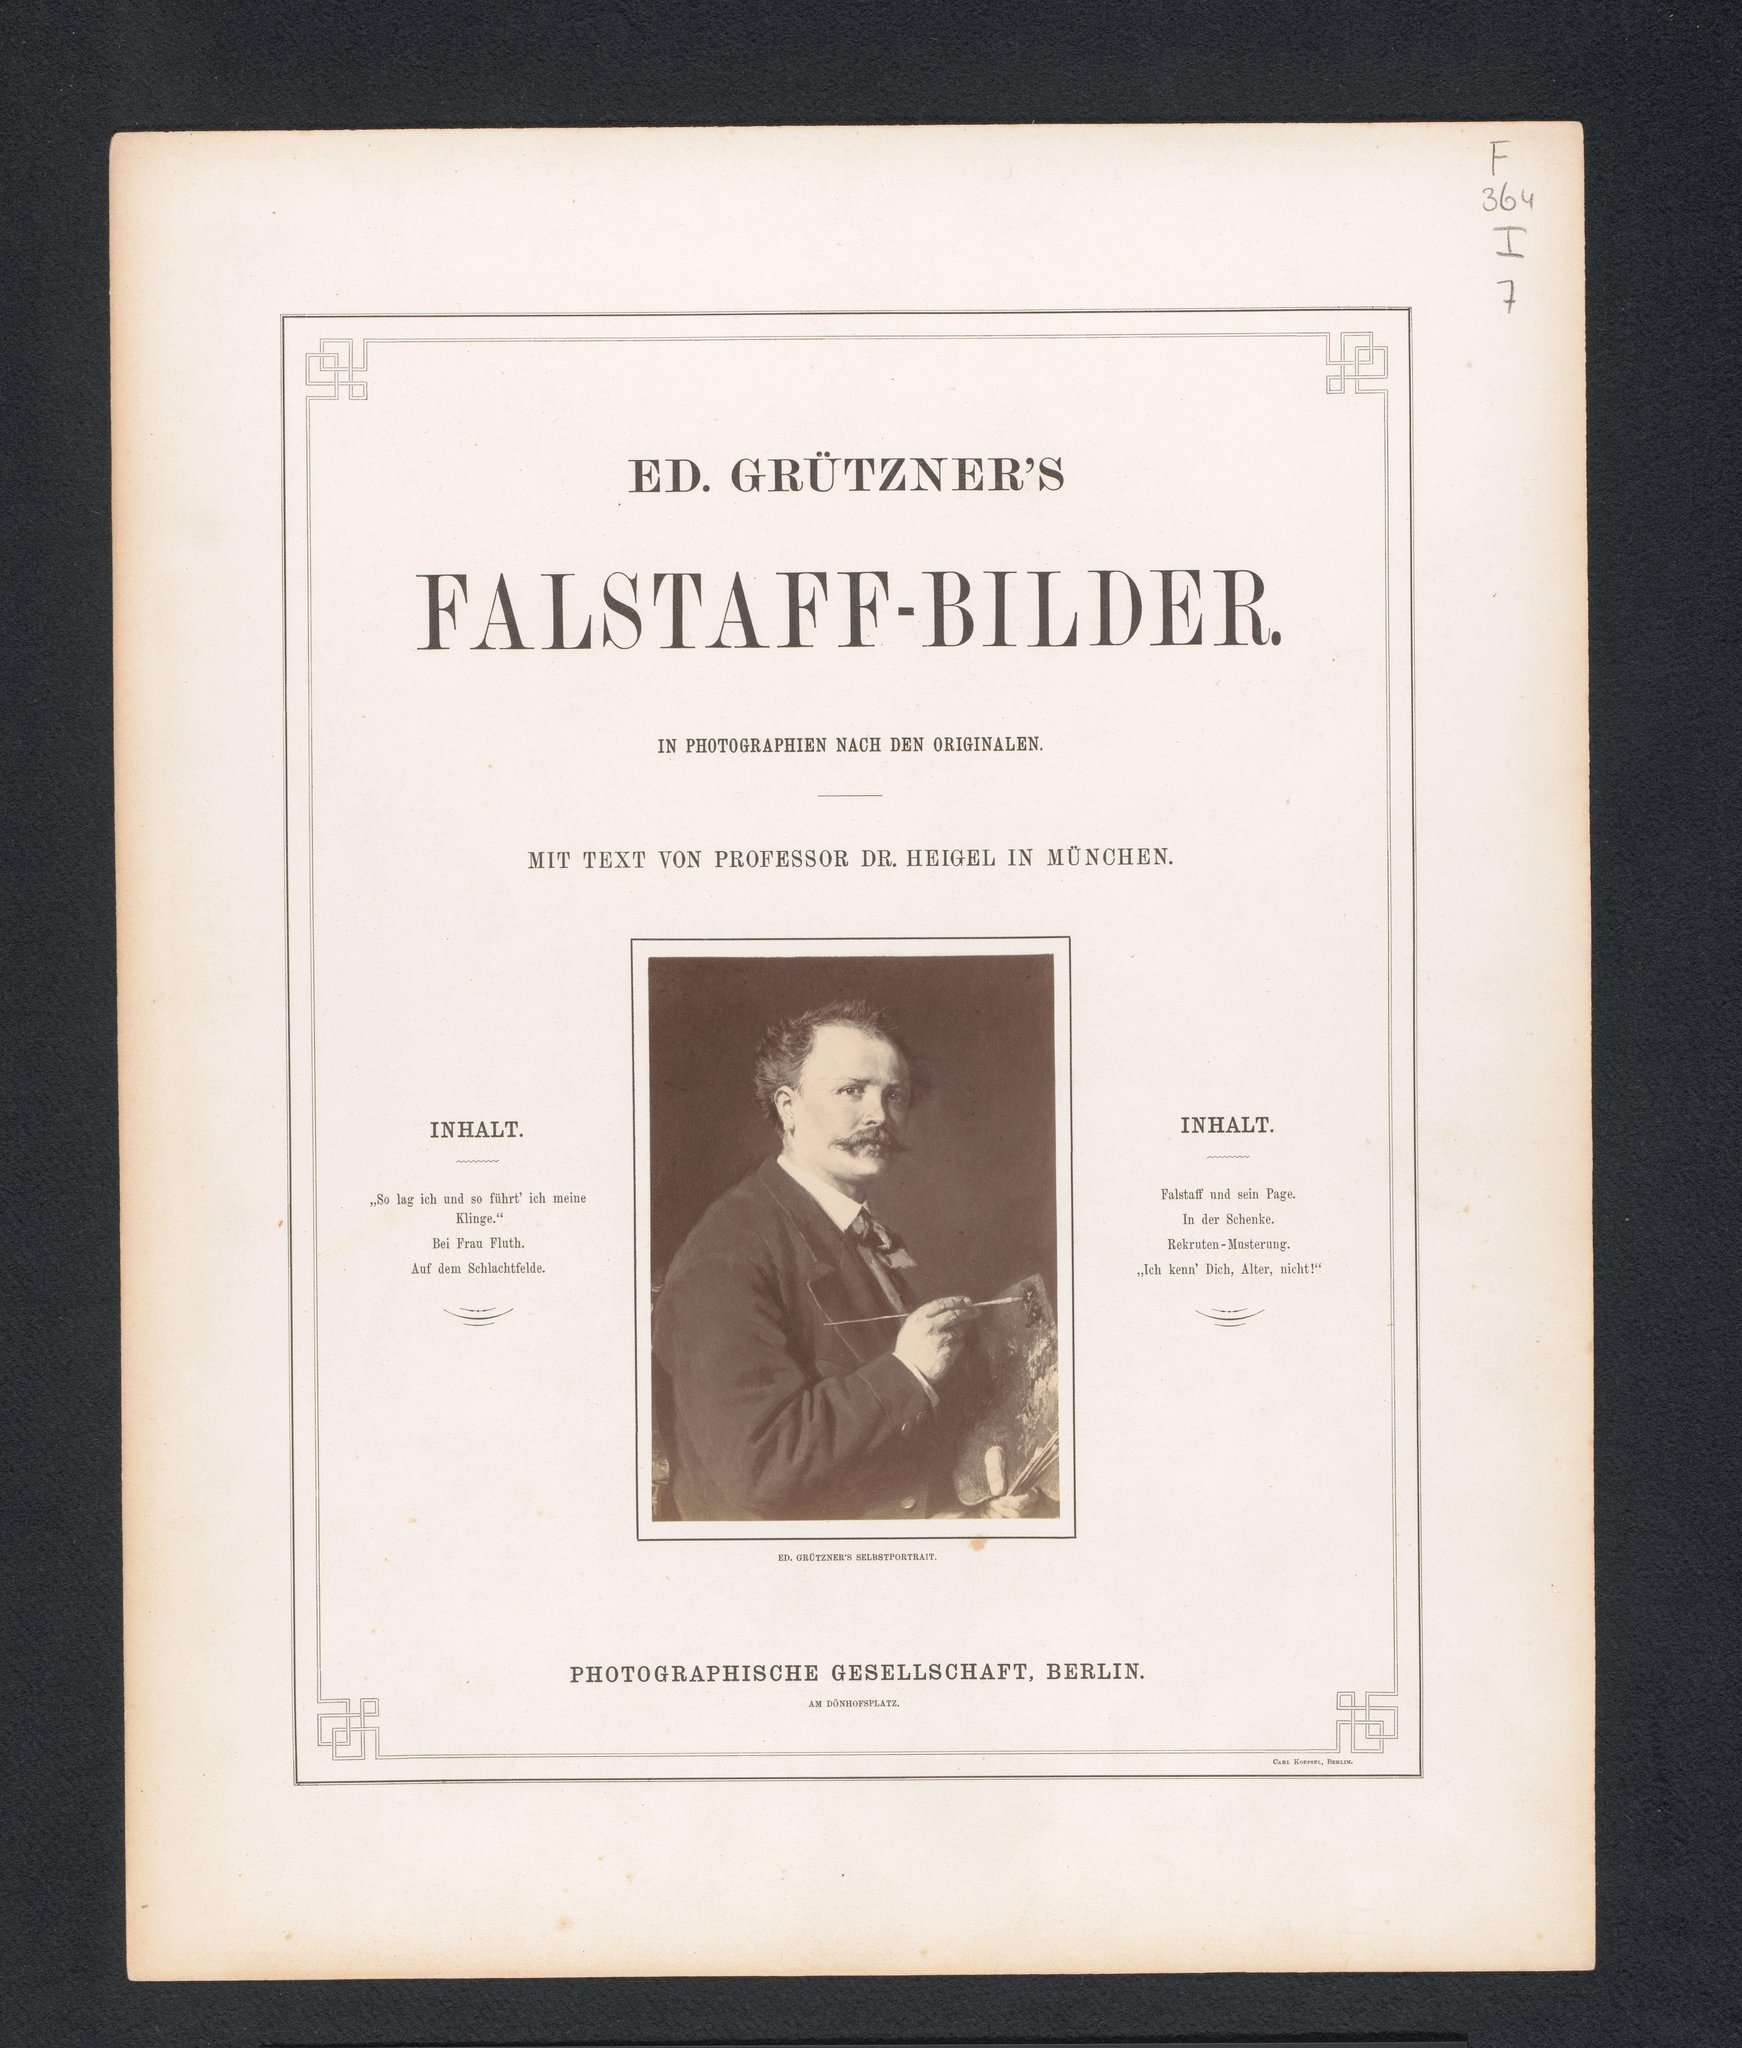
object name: wrapper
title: Ed. Grützner's Falstaff-Bilder / mit text von Professor Dr. Heigel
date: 1878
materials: cardboard, linen, paper, photographic support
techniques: albumen print, printing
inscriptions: date: ‘MAR 1982’, retailer's mark: ‘WILH. SCHÄFFEL/ DAMPFBUCHBINDEREI/ LEIPZIG’, bookplate: ‘EX/ SFJ/ LIBRIS’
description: Omslag met zeven foto's, een titelblad met foto en een tekstblad.